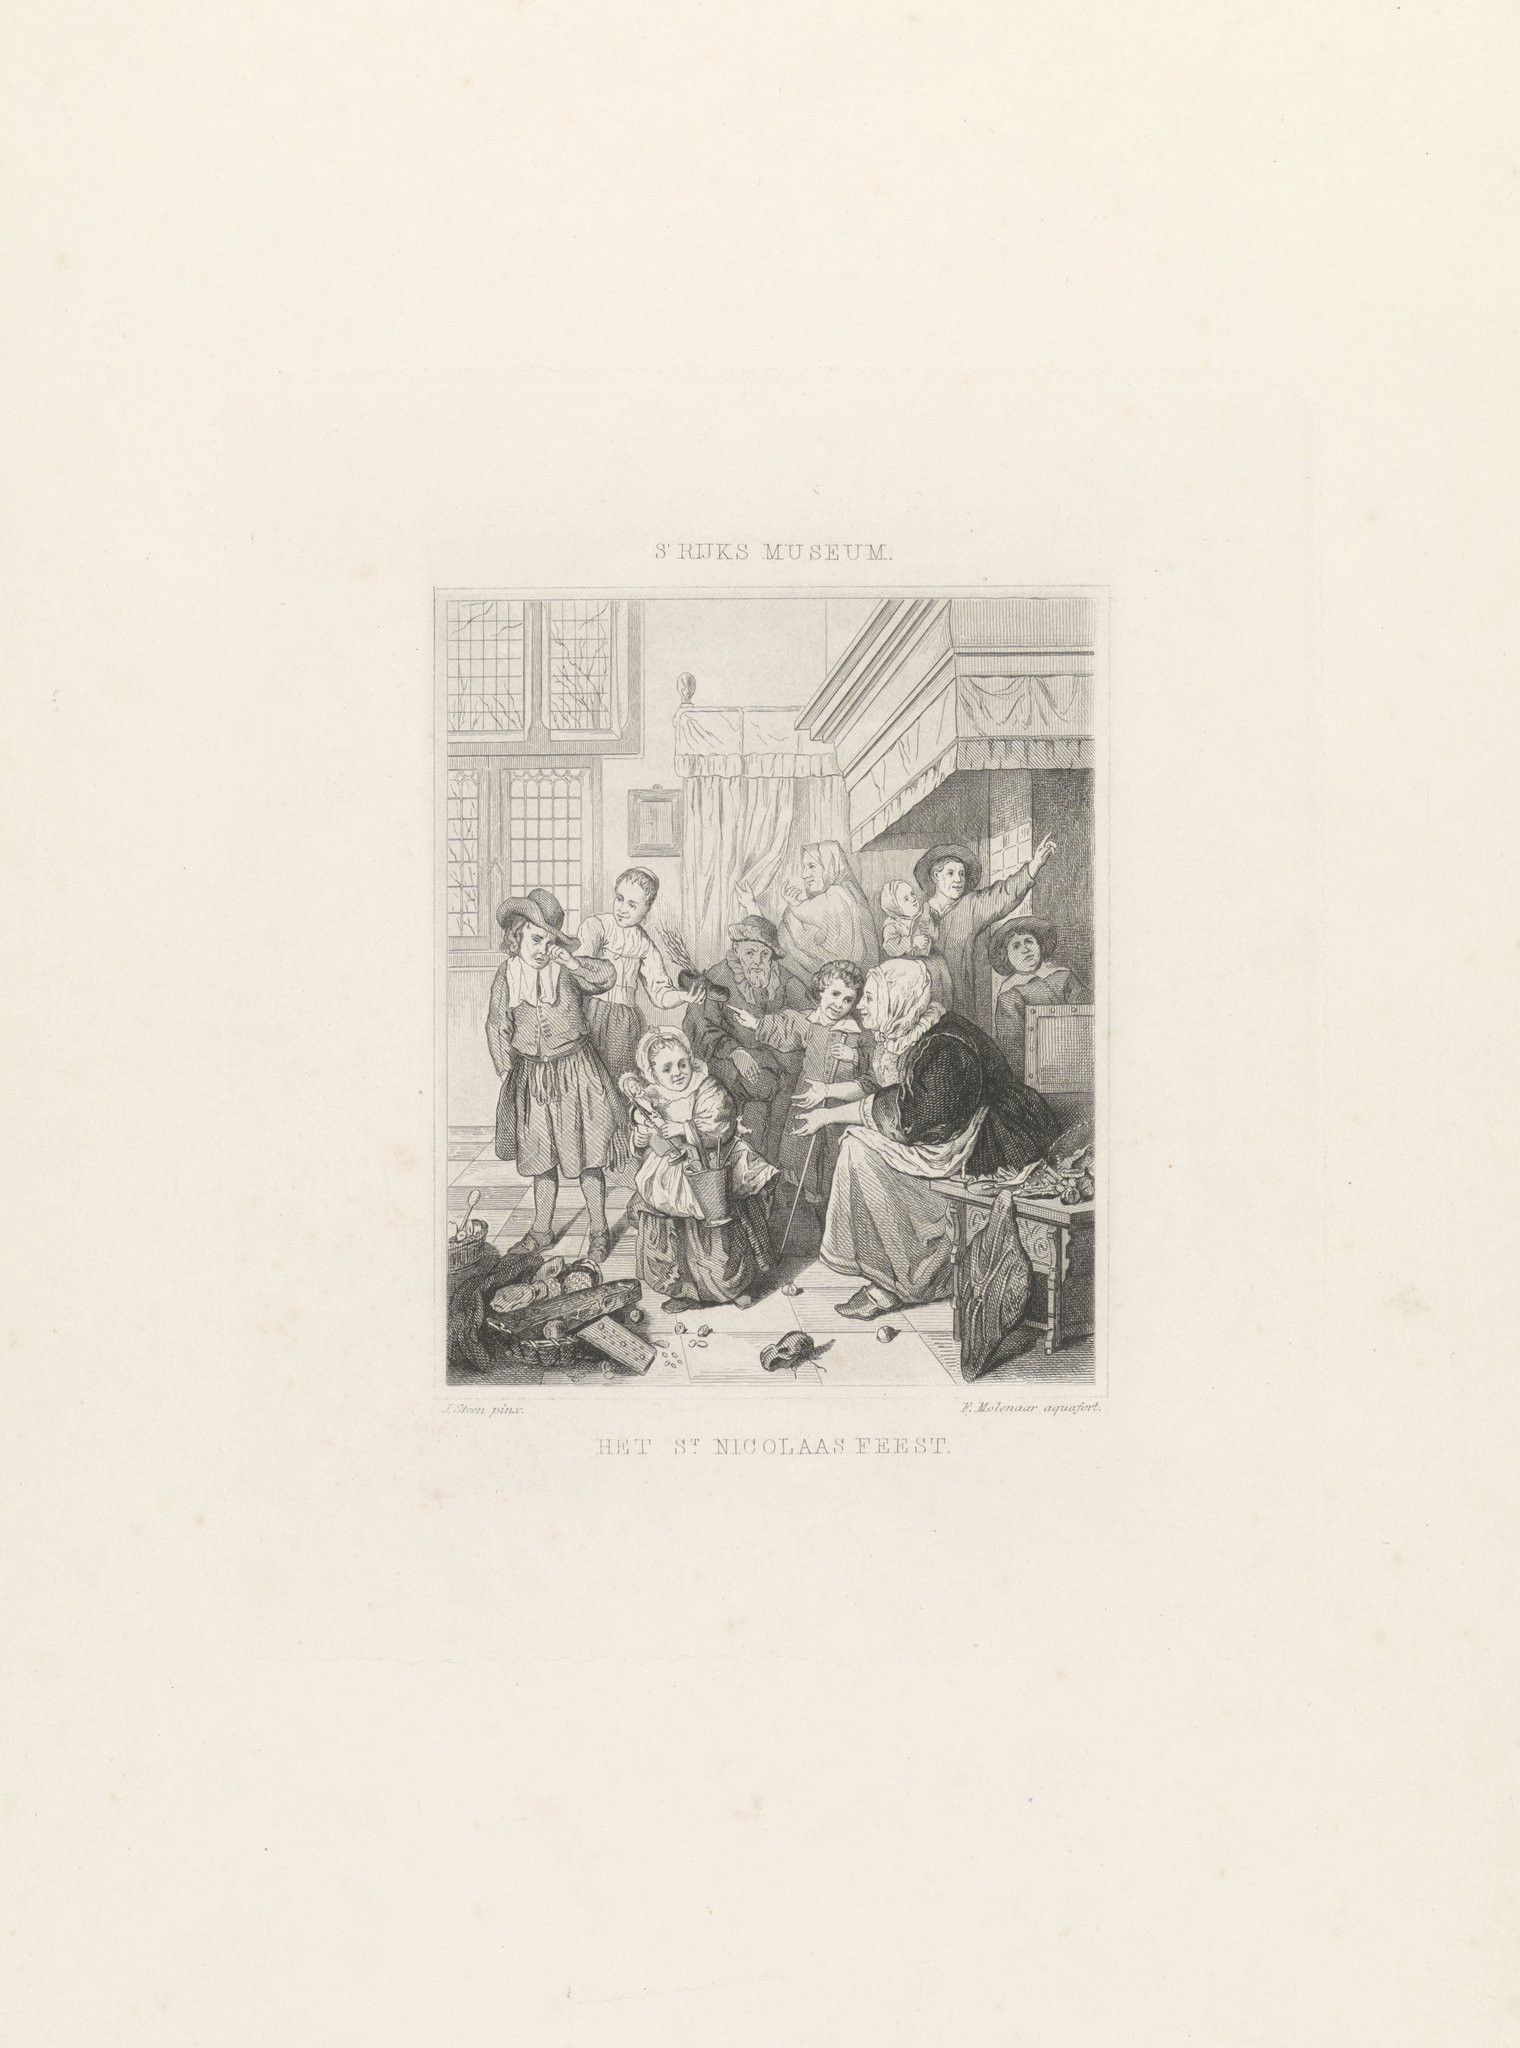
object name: print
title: Sint Nicolaasfeest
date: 1831-1886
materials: paper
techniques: etching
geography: amsterdam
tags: festivities on st. nicholas (eve) (december 5)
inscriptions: collector's mark: Lugt 2228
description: Interieur waarin een 17de-eeuwse familie het Sint Nicolaasfeest viert. In het midden een meisje met een Johannes de Doper-pop en een emmer met snoep. Links een huilende jongen die een roe in zijn schoen heeft gekregen. Naast de moeder staat een jongen met een kolfstok. Op de vloer een mand met koeken en broodjes; bij de schoorsteen zingende jongeren. Op de achtergrond een oudere man en vrouw.